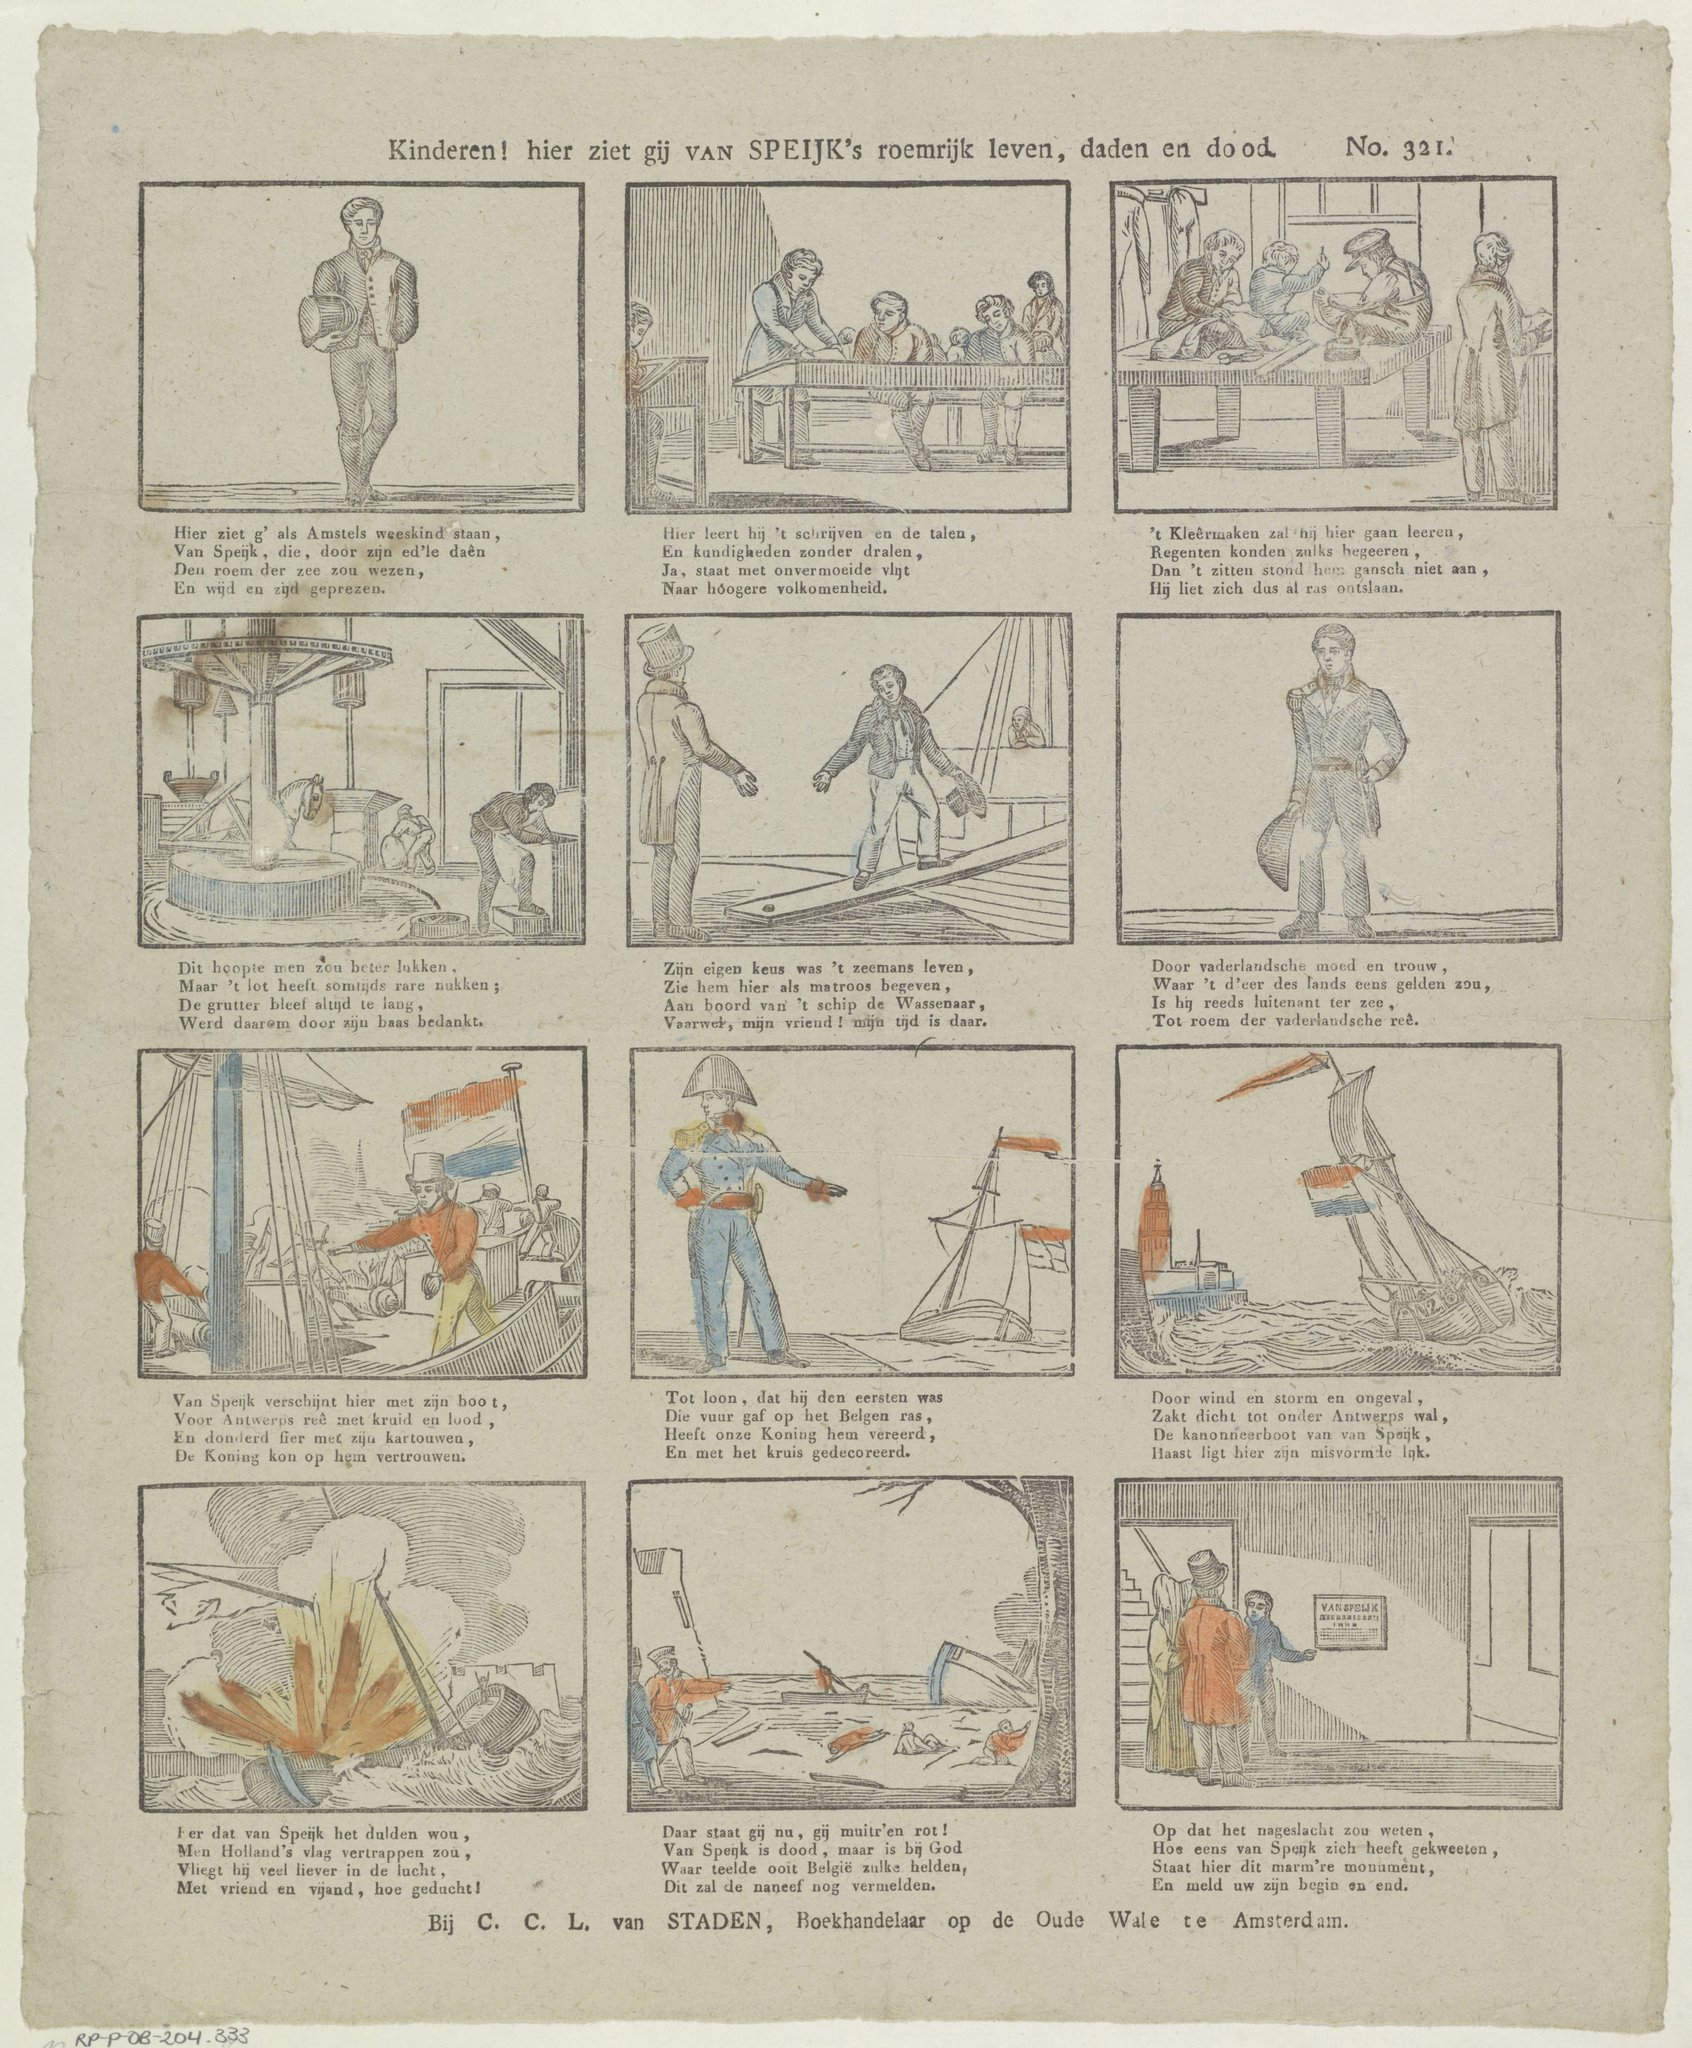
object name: print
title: Kinderen! hier ziet gij van Speijk's roomrijk leven, daden en dood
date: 1830-1870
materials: paper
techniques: colour, letterpress printing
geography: zaltbommel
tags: amsterdam, antwerp, jan van speyk, battle, revolution, revolt, orphans, belgium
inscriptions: collector's mark: Lugt 2760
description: Blad met 12 voorstellingen over het leven en de zelfopoffering van J.C.J. van Speyk tijdens de strijd tegen de Belgen. Onder elke afbeelding een vierregelig vers. Genummerd rechtsboven: No. 321.